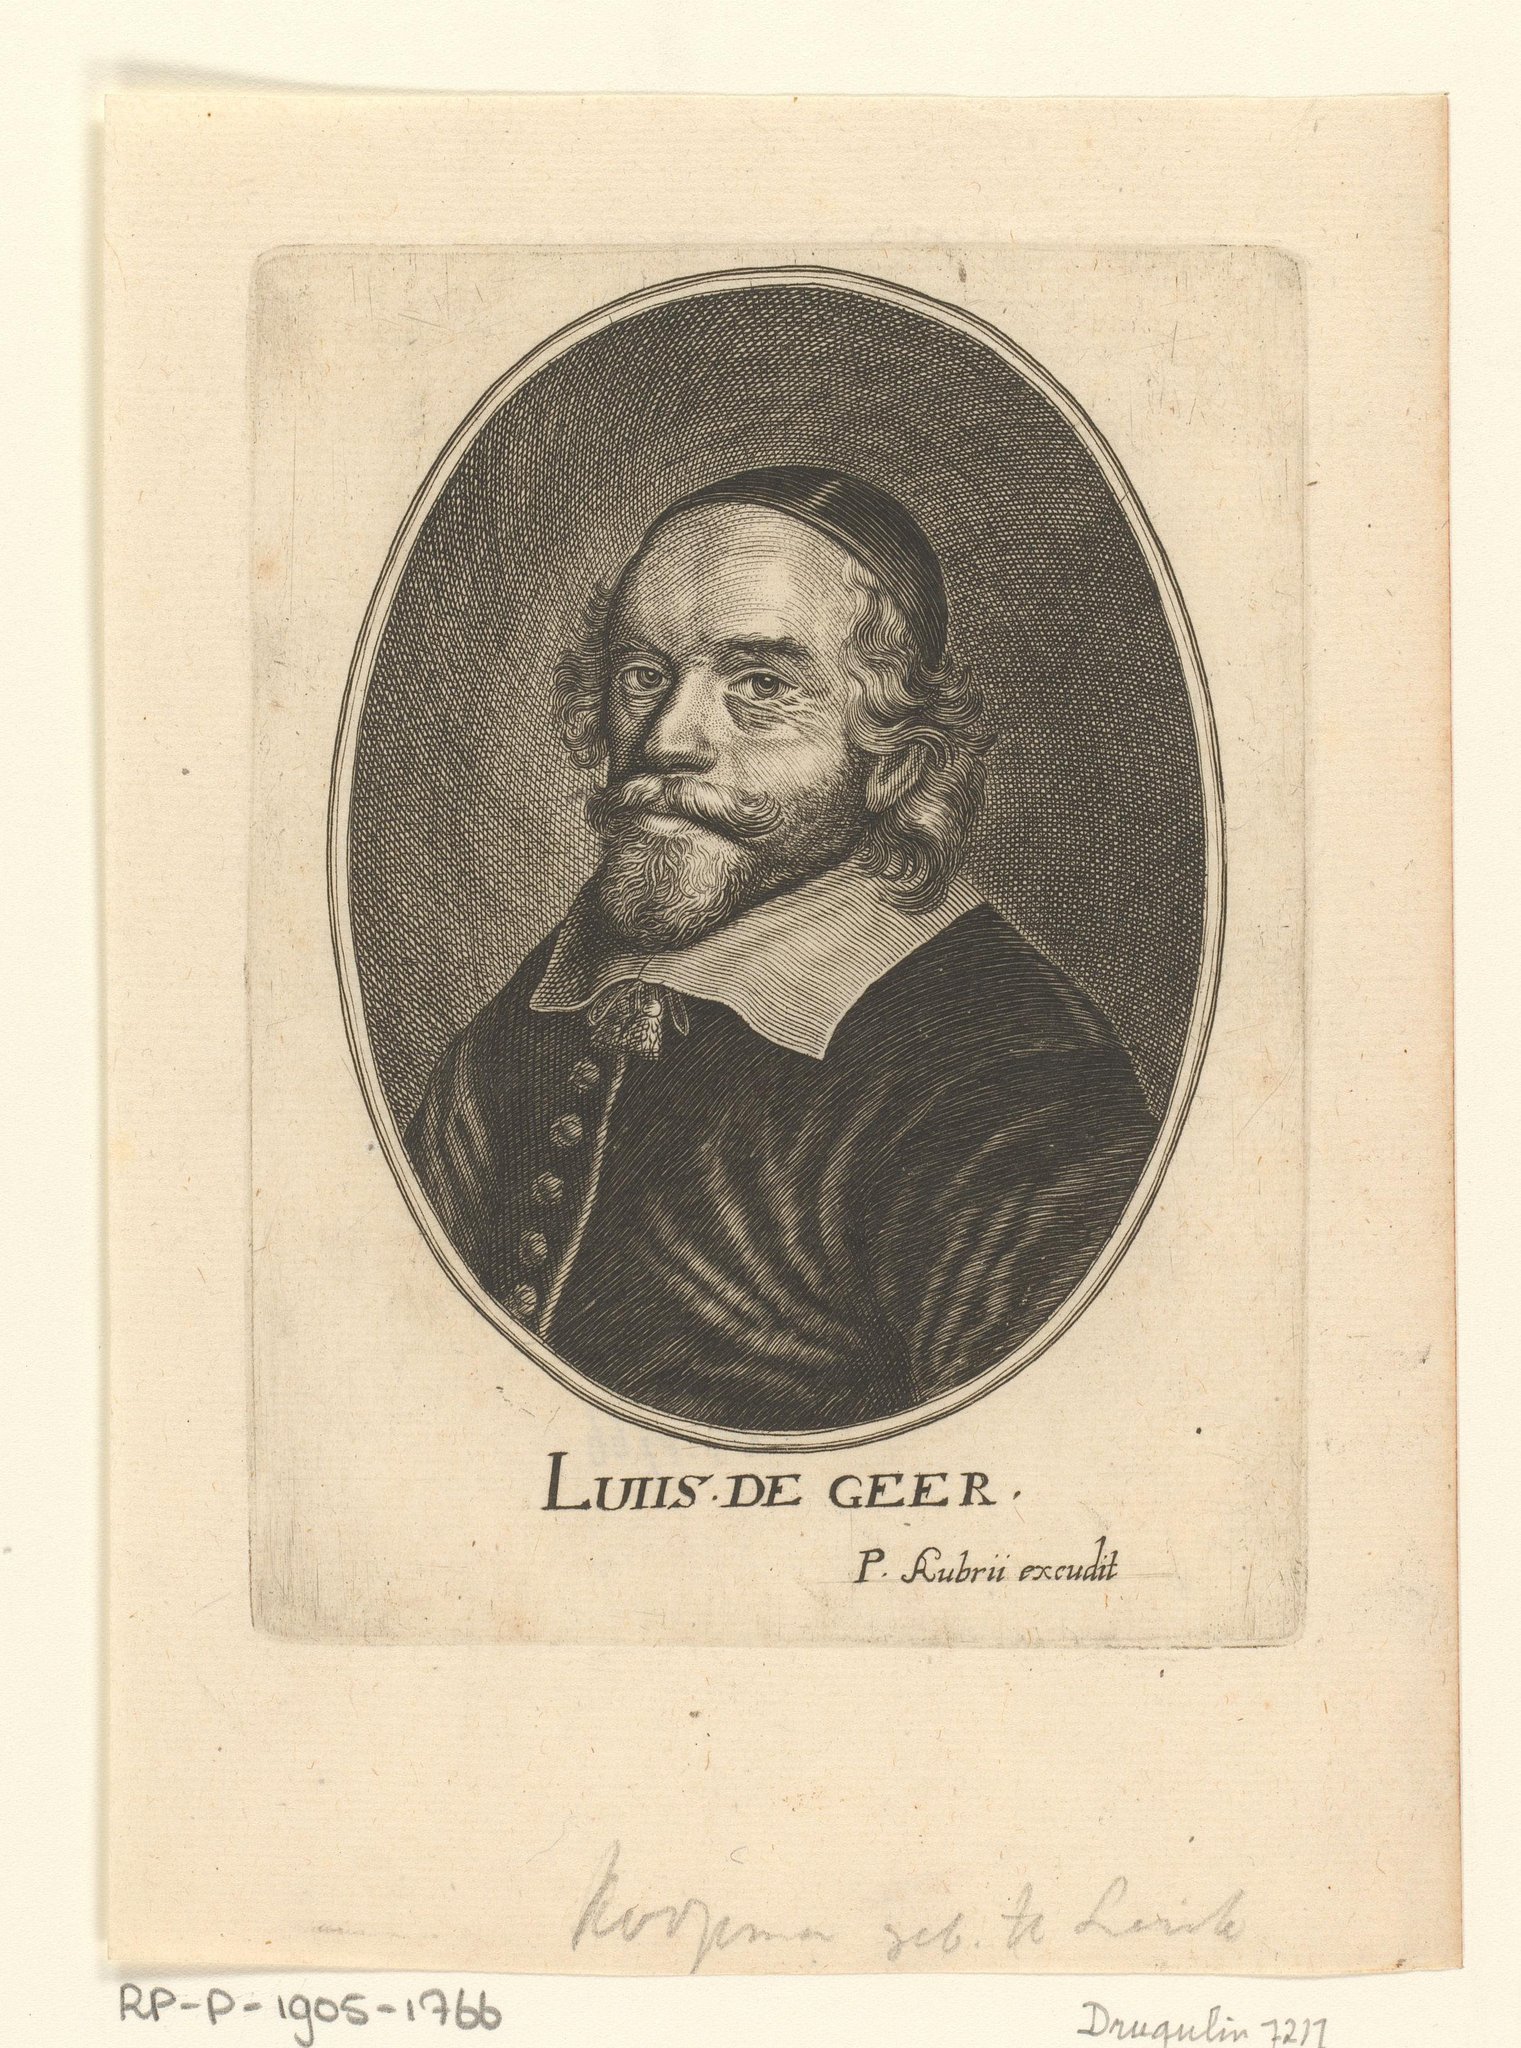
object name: print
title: Portret van Louis de Geer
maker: Anonymous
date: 1627-1686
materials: paper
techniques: engraving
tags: liège, amsterdam, historical persons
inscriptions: collector's mark: Lugt 2228